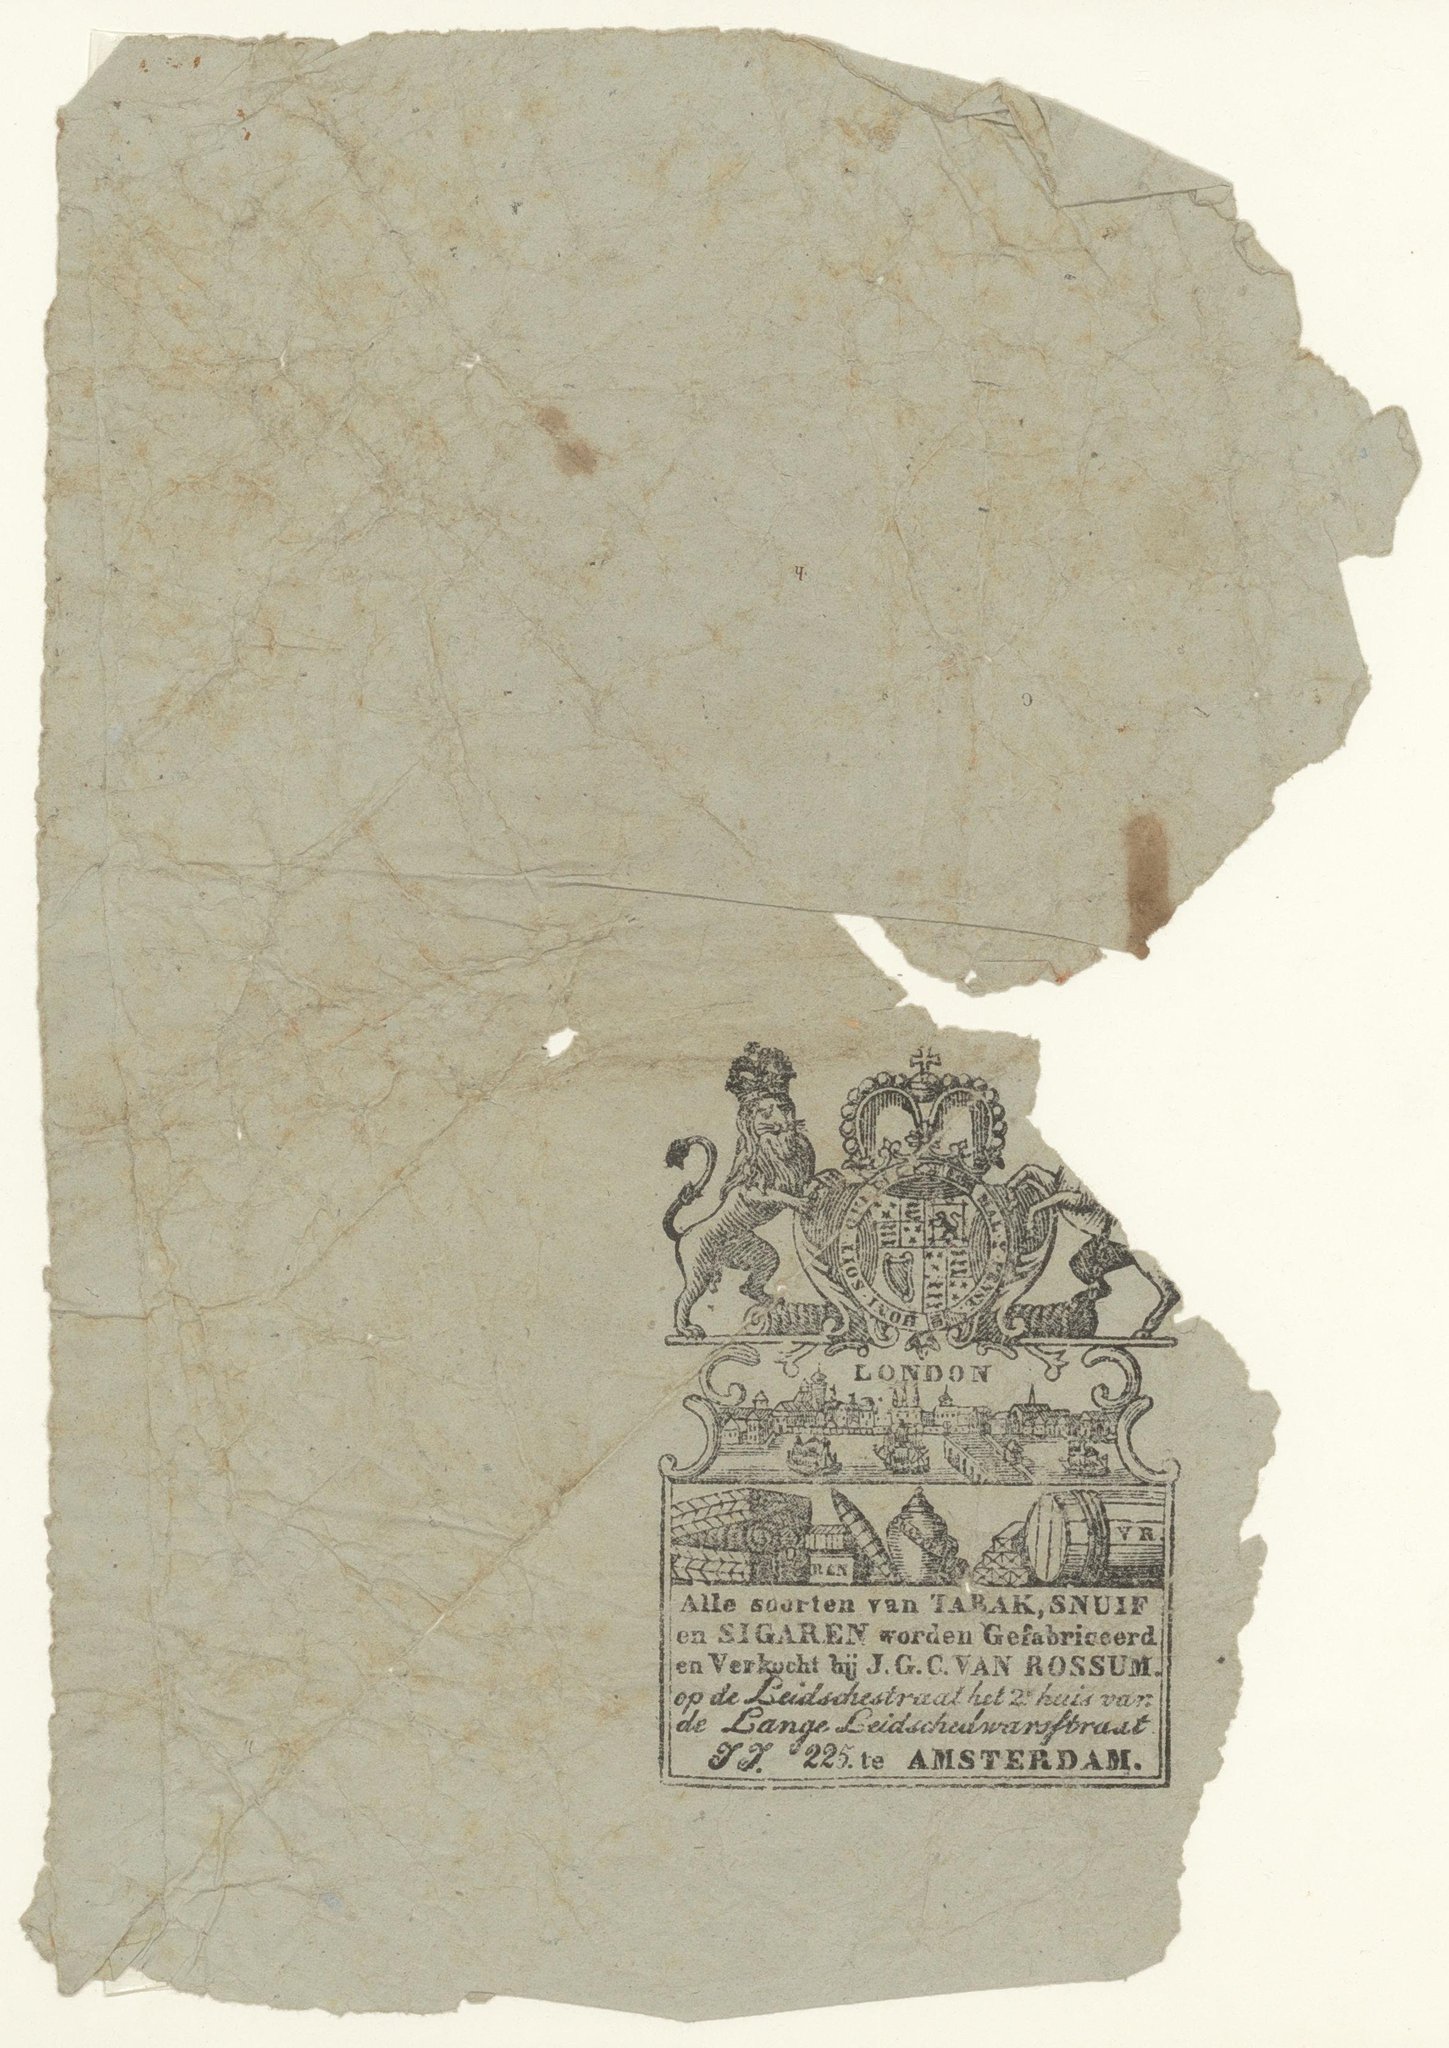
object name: print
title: Verpakking van tabak en sigaren van J.G.C. van Rossum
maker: Anonymous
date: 1852-1875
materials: paper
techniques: woodcut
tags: ships (in general), tobacco, amsterdam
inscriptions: collector's mark: Lugt 1641, stamp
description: Verpakking van tabak en sigaren van J.G.C. van Rossum. Zijn winkel bevindt zich op de Lange Leidsedwarsstraat te Amsterdam. Op de verpakking is een wapen met twee leeuwen en de haven van Londen afgebeeld. Onderwerpsrubrieken binnen de Atlas Zeden en Gewoonten: Handel, nijverheid en verkeer, Koophandel, Veilingen, Makelaardij en Verzekeringswezen, Oude adreskaarten van winkels en fabrieken, reclame.